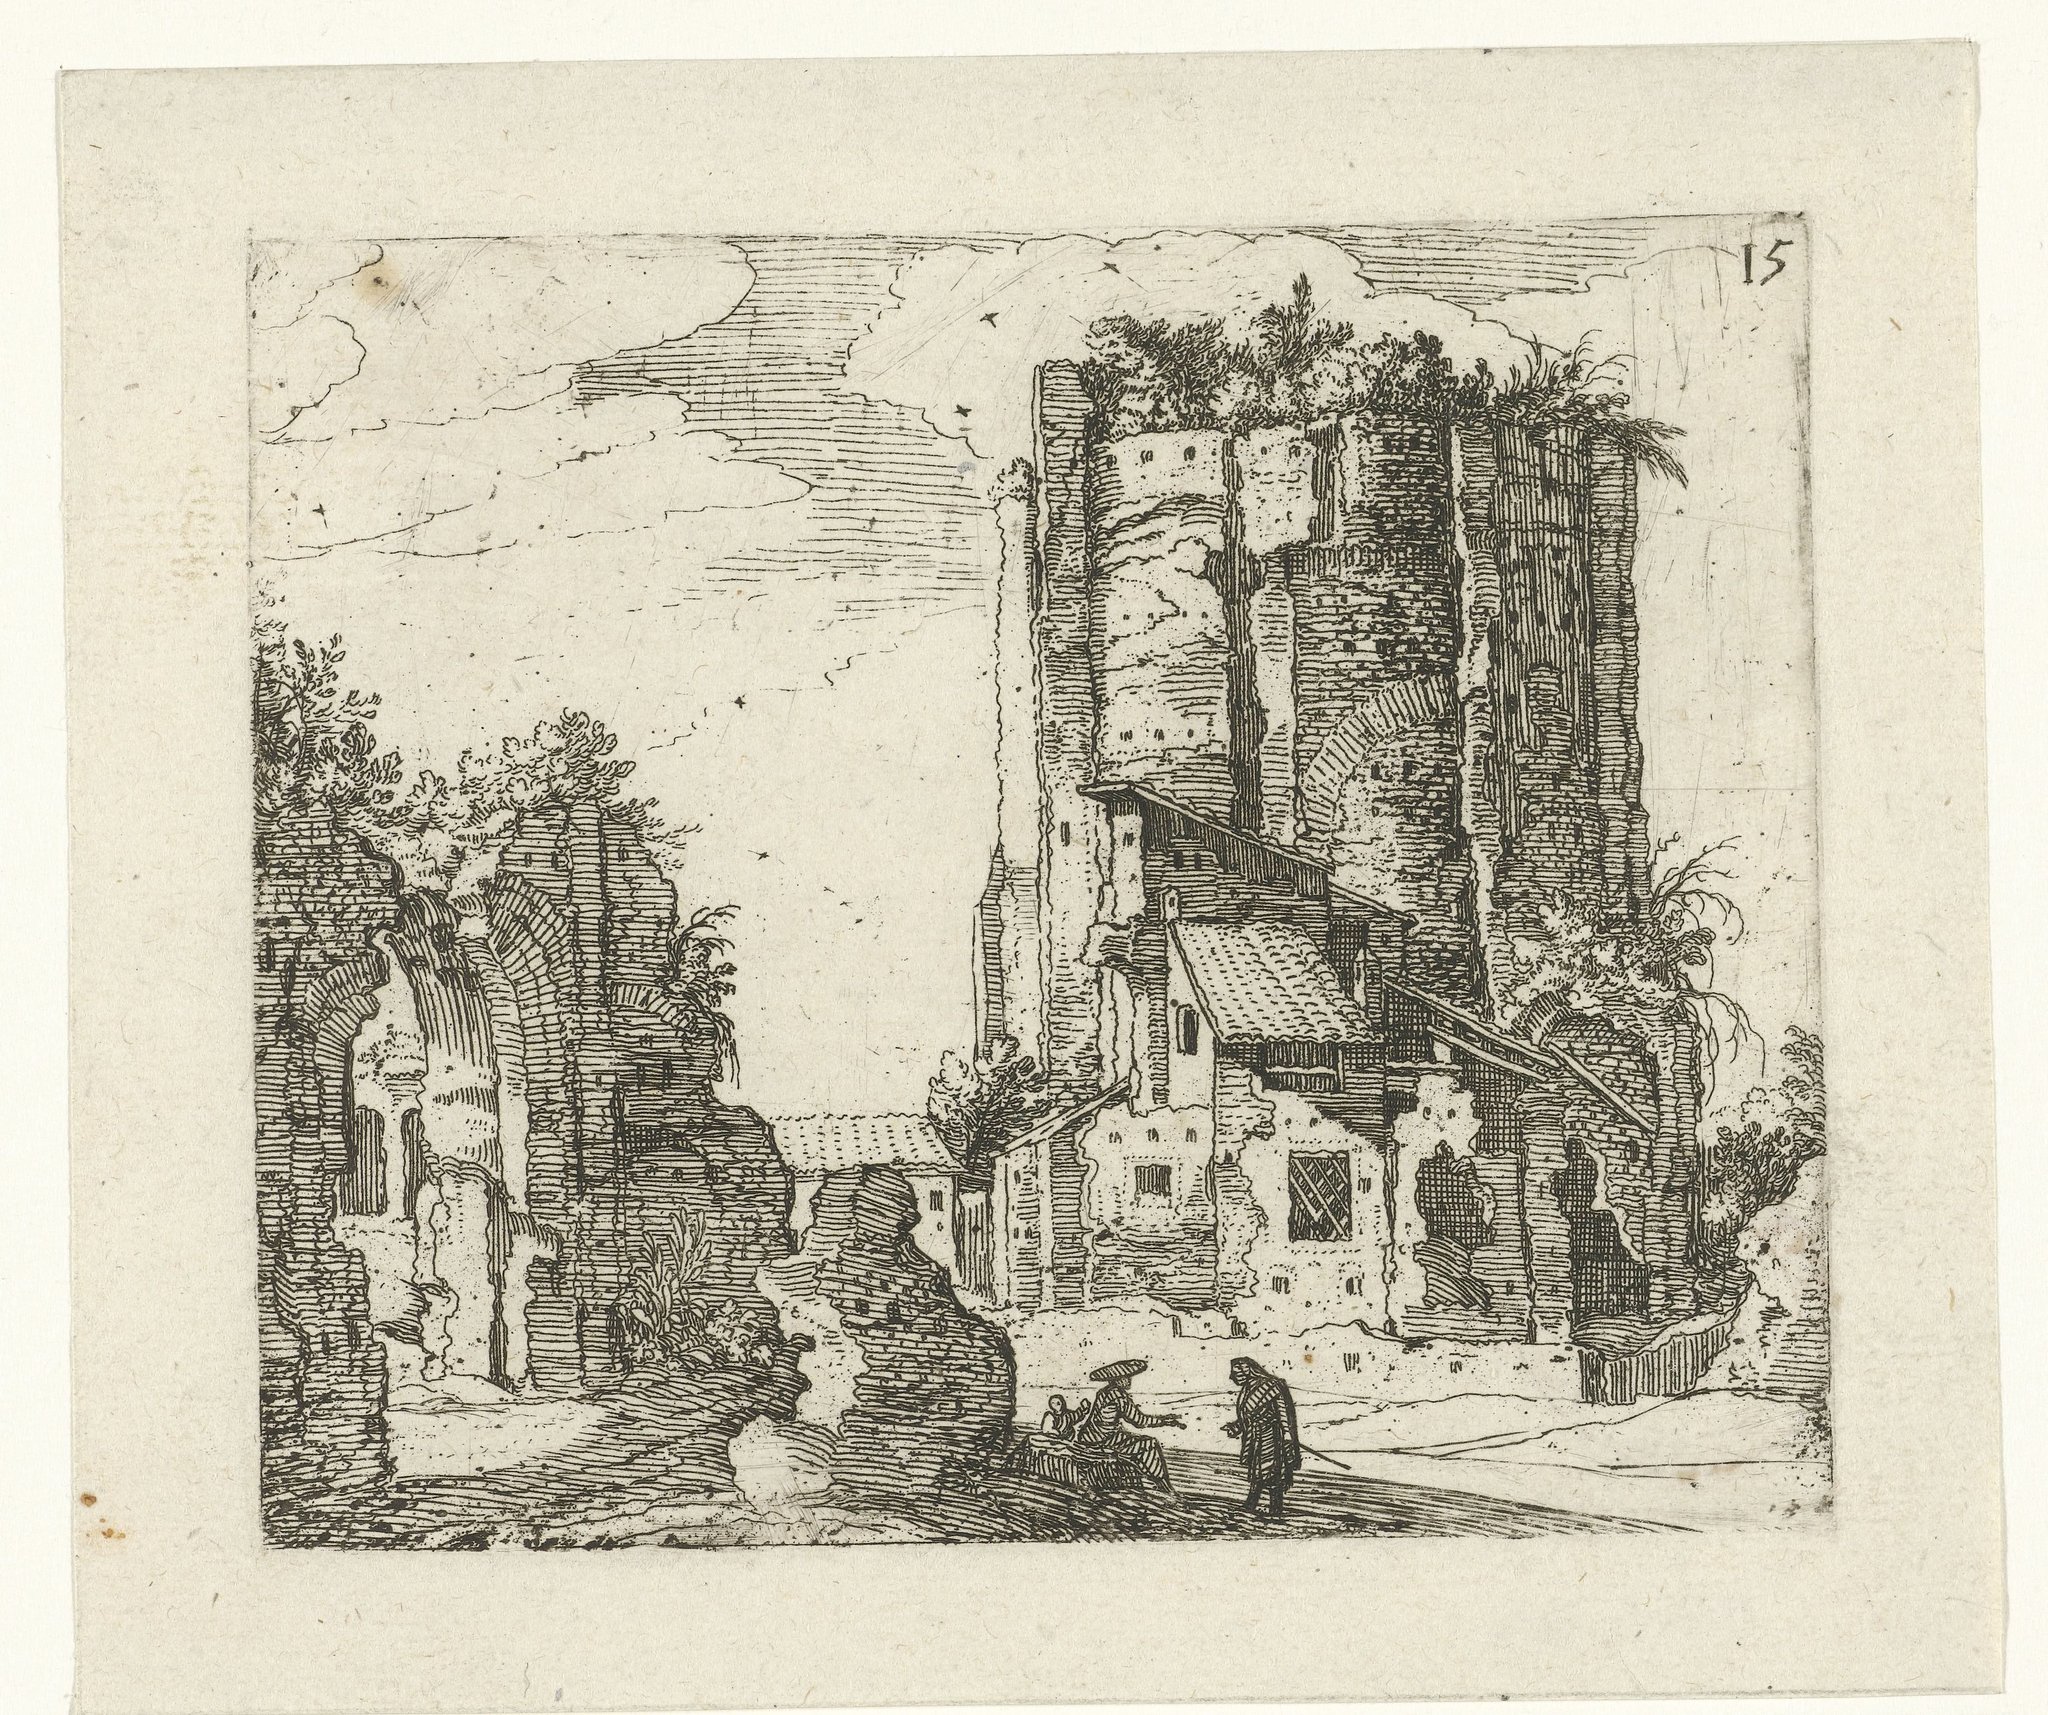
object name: print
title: Romeinse ruïnes (serie 1)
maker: guilliam van nieulandt (ii)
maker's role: draughtsman, print maker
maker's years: 1584-1635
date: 1594-1618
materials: paper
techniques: etching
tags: landscape with ruins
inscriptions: collector's mark: Lugt 240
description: Rechts de ruïne van een toren, links een andere ruïne in het landschap. Prent uit een serie Romeinse ruïnes.